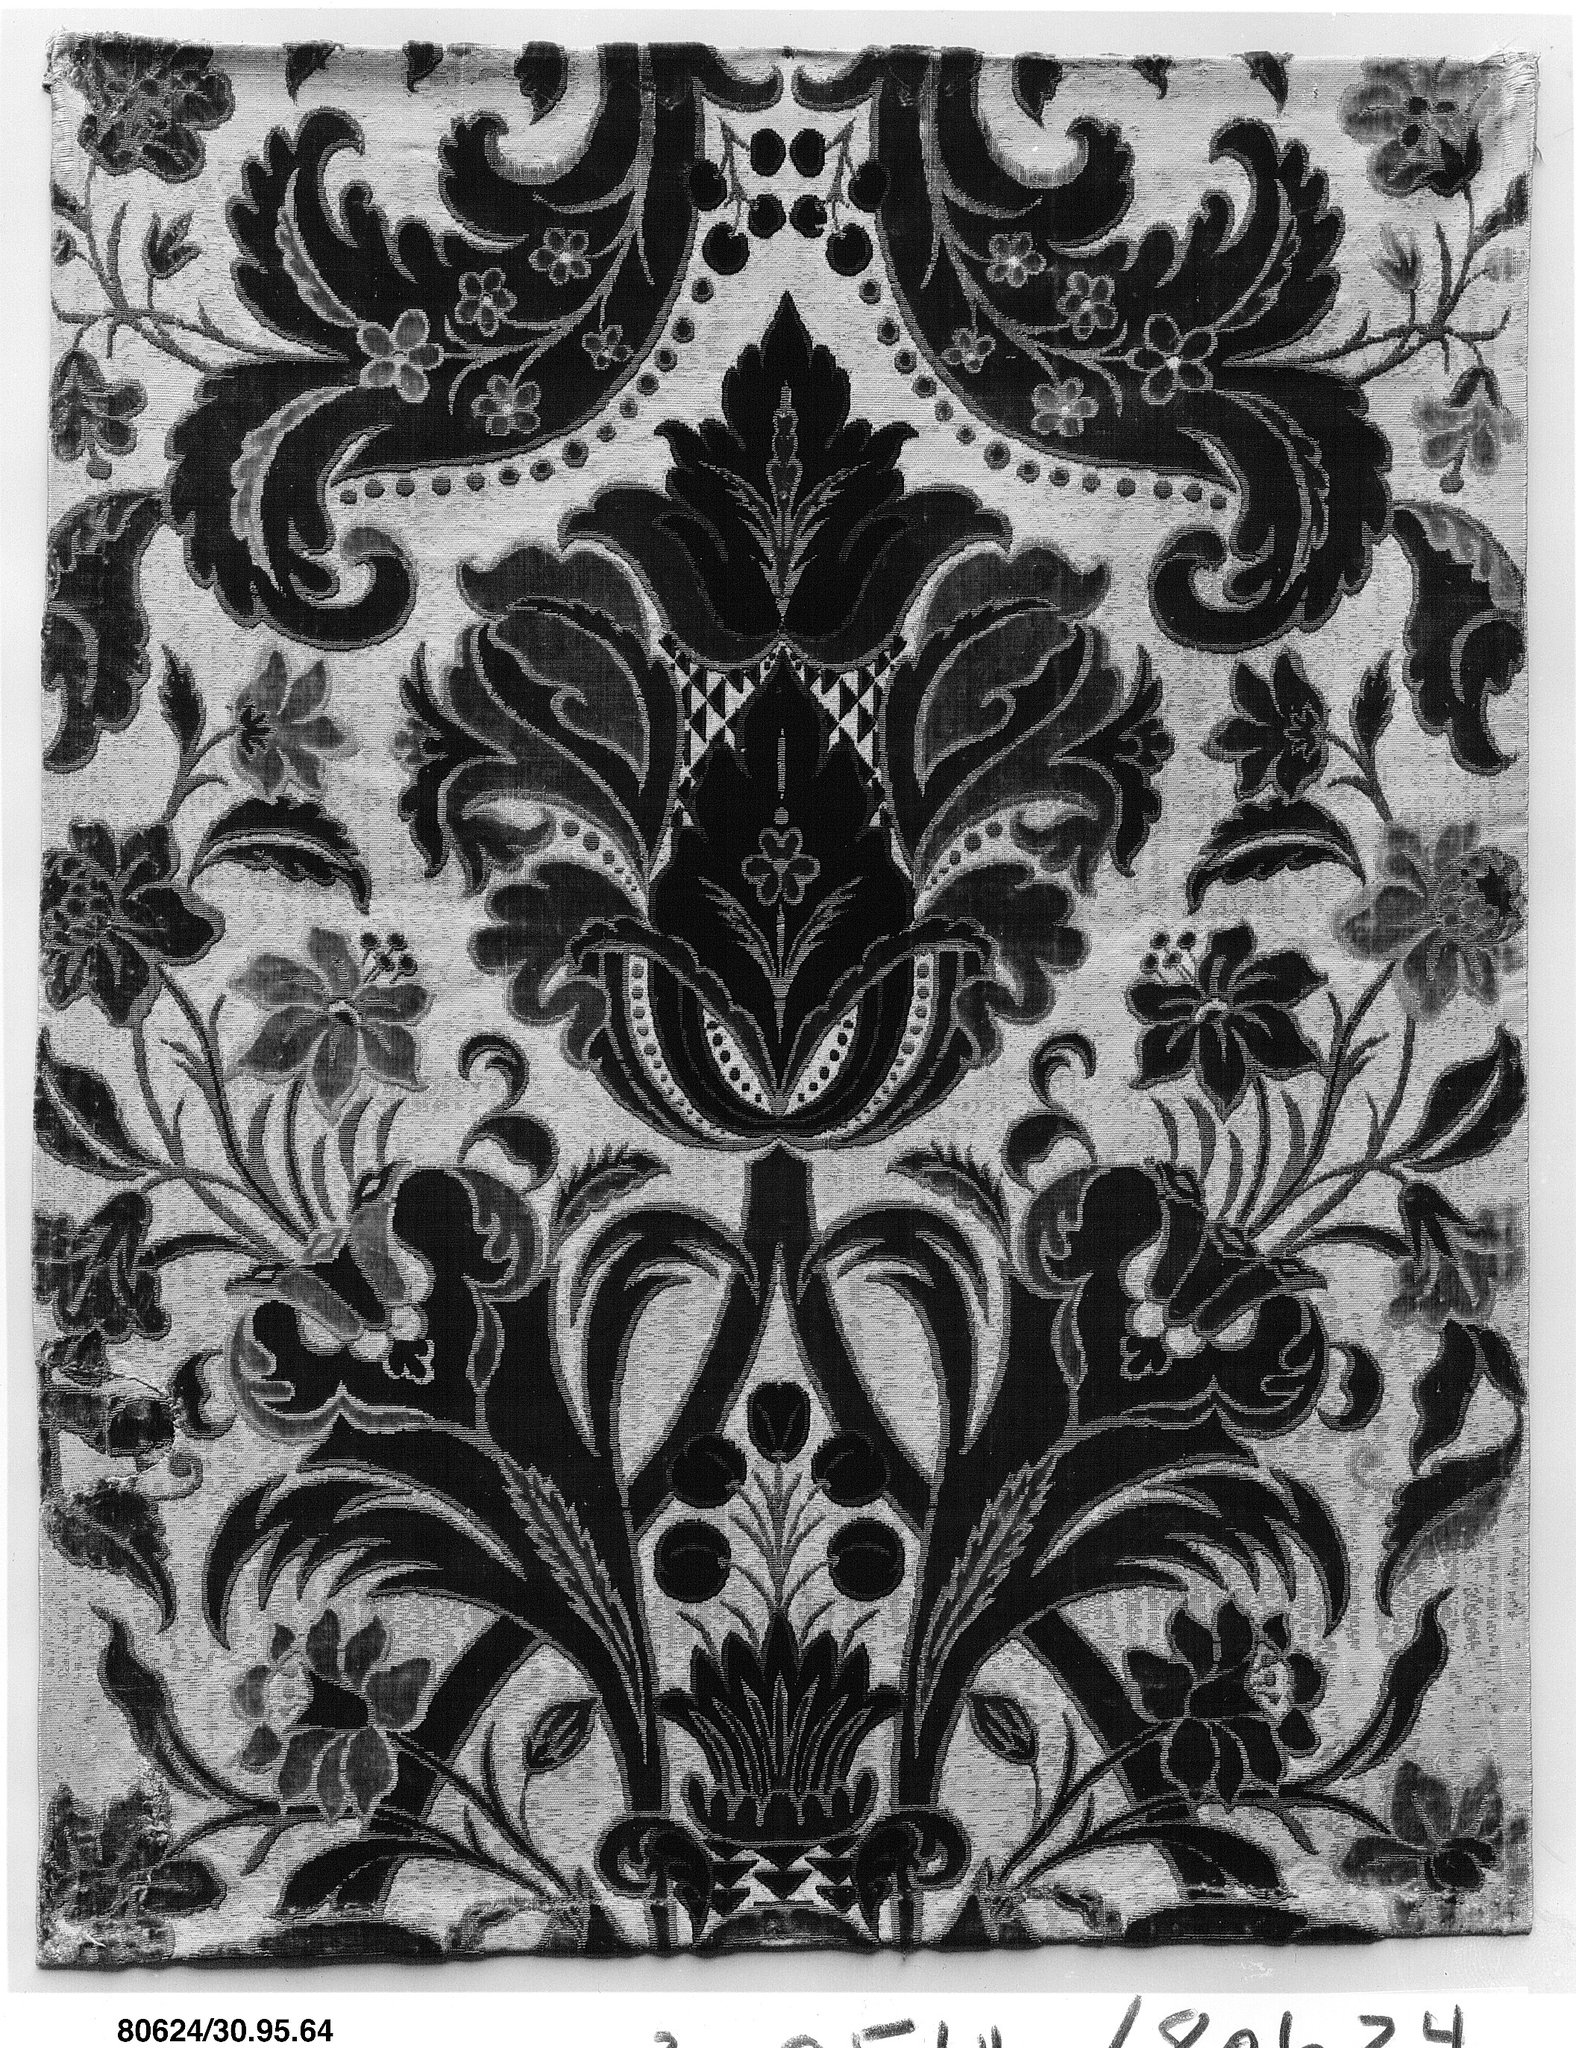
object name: piece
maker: albergo di virtù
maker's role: manufactory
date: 1716-1719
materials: metal thread, silk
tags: flowers,leaves